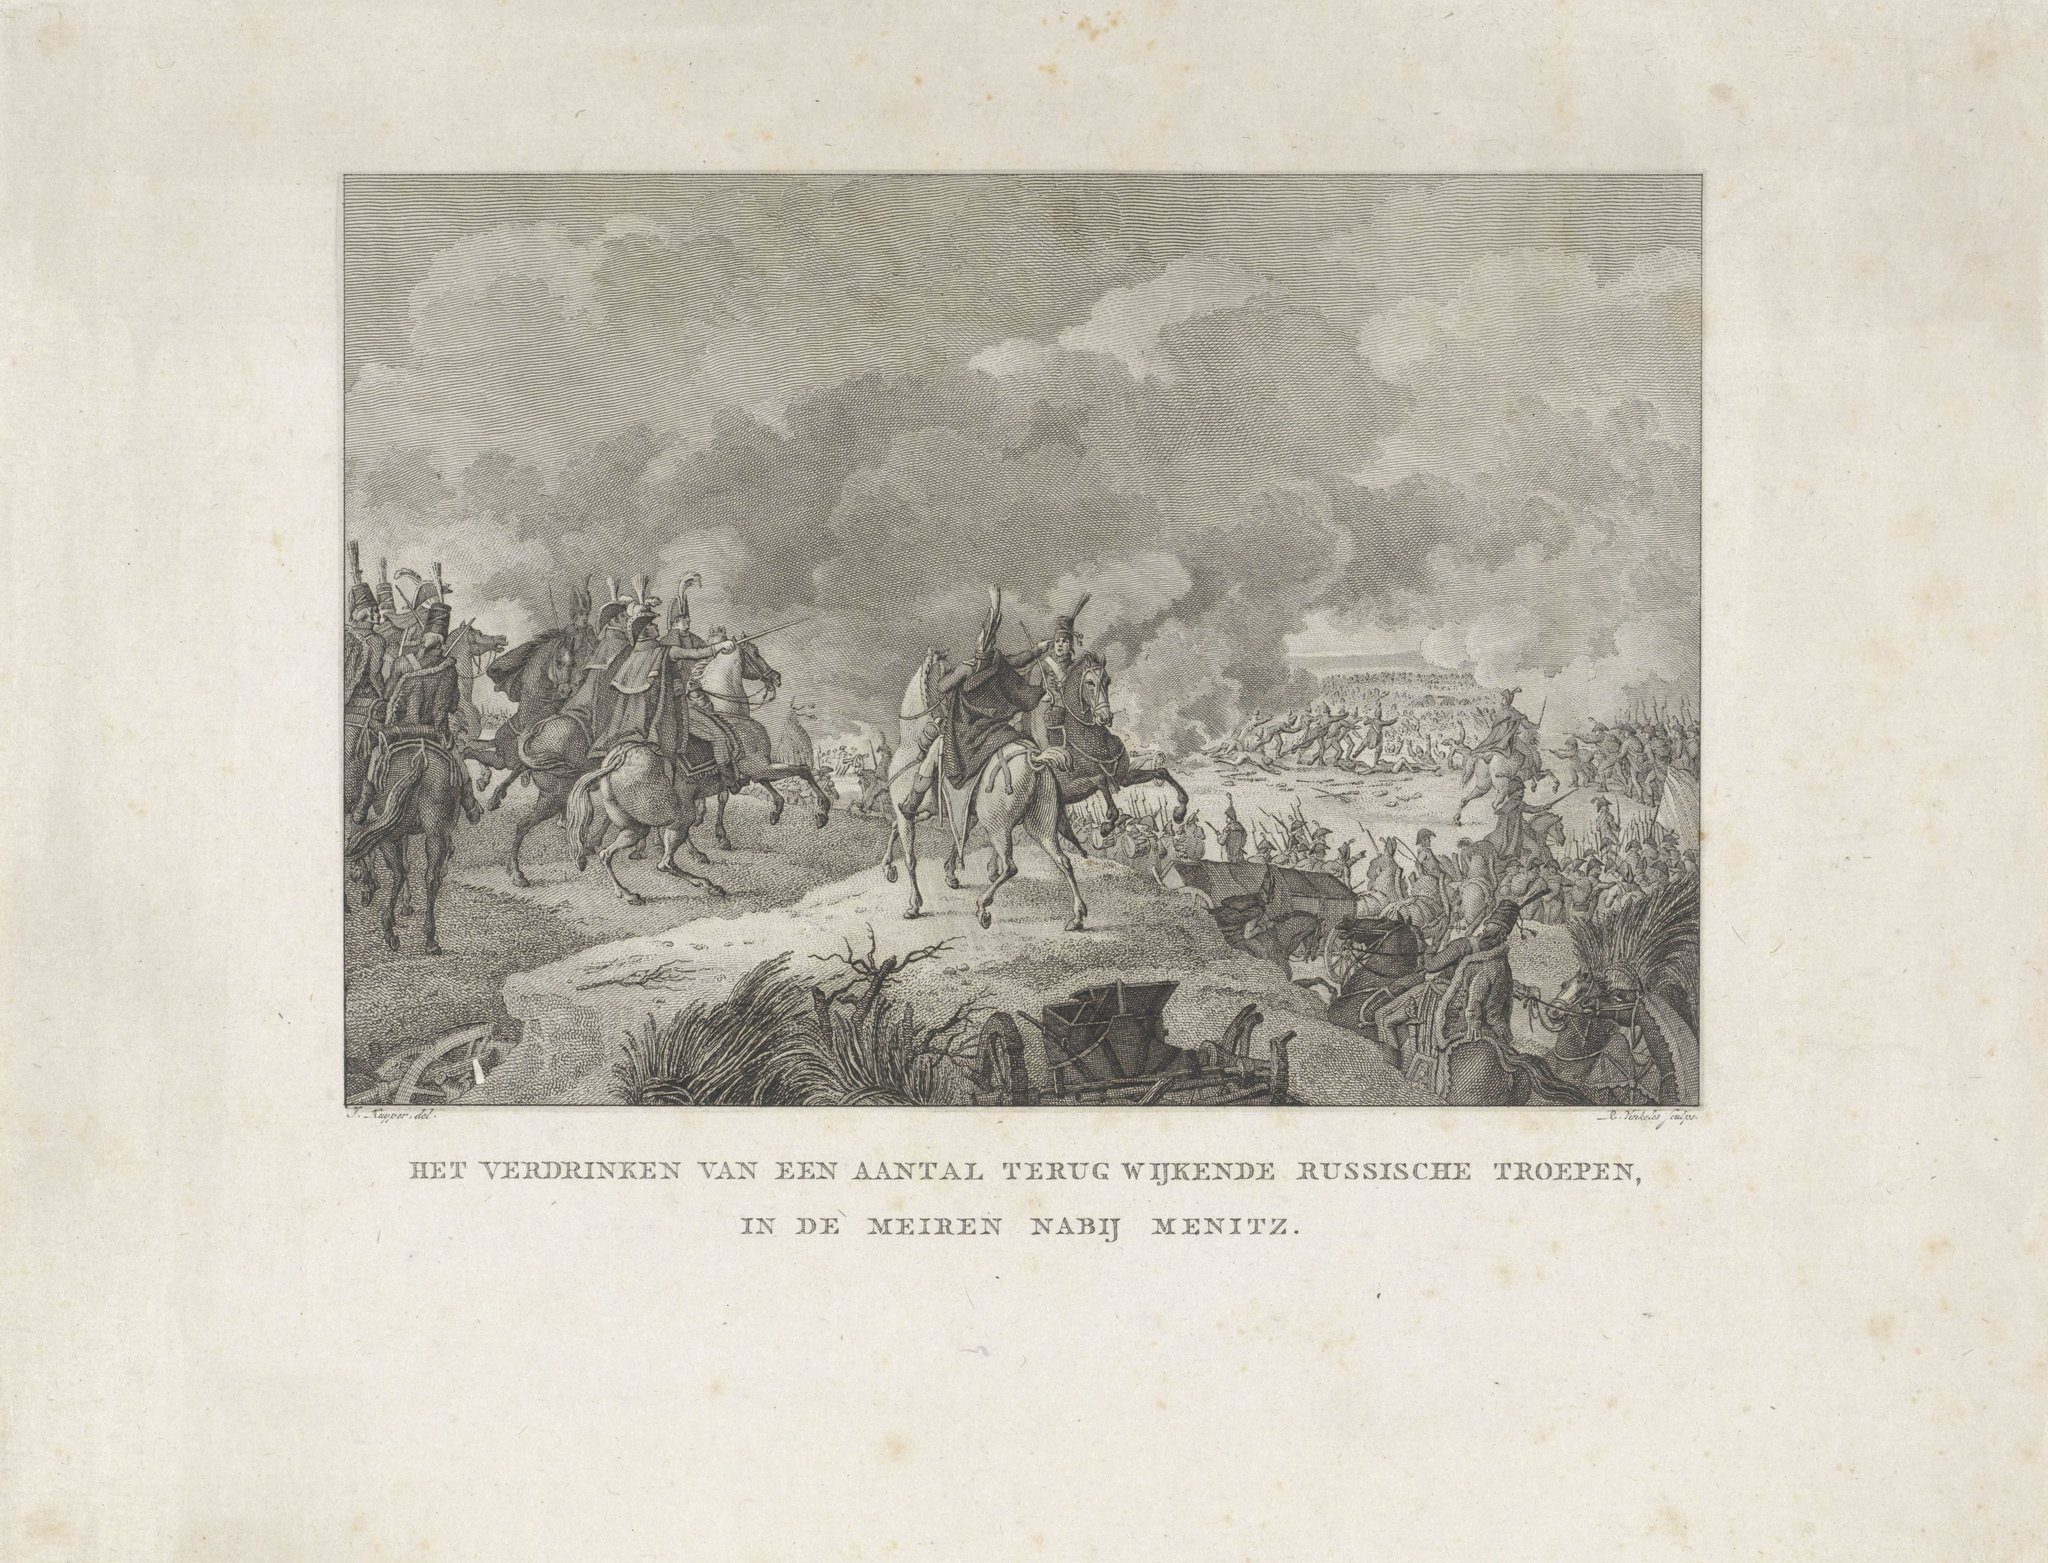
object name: print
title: Ruiters op een slagveld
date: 1751-1816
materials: paper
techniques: engraving, etching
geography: amsterdam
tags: battle (+ cavalry, horsemen)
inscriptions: collector's mark: Lugt 240